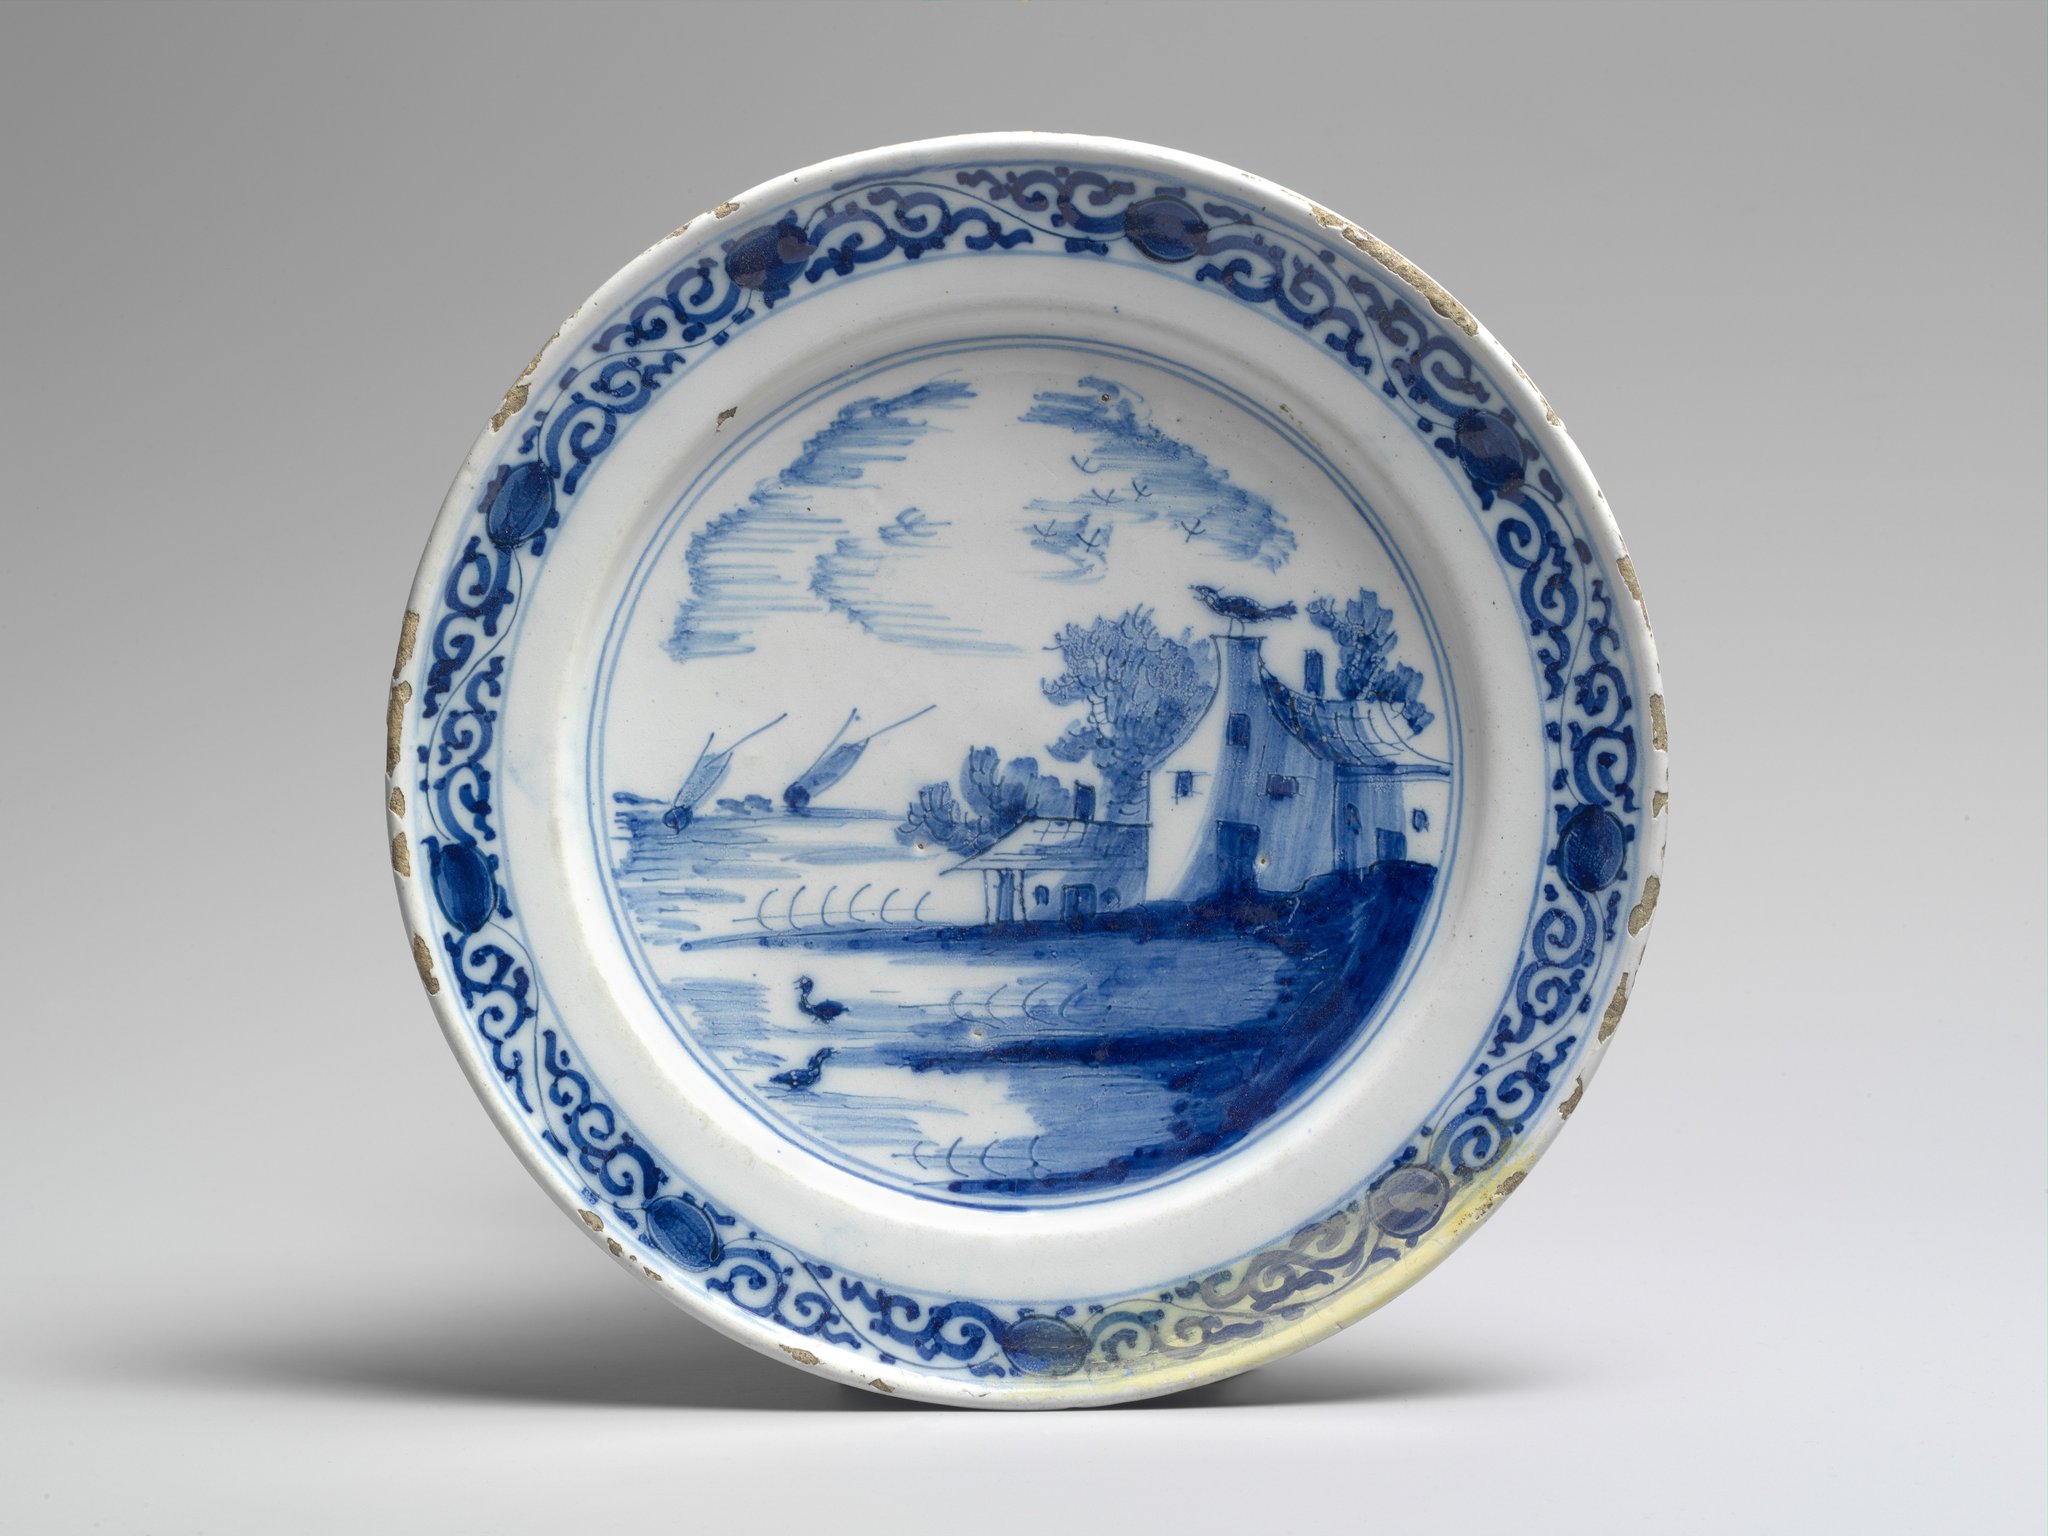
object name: dish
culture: dutch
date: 1704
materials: earthenware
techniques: glazing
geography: netherlands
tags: houses,landscapes